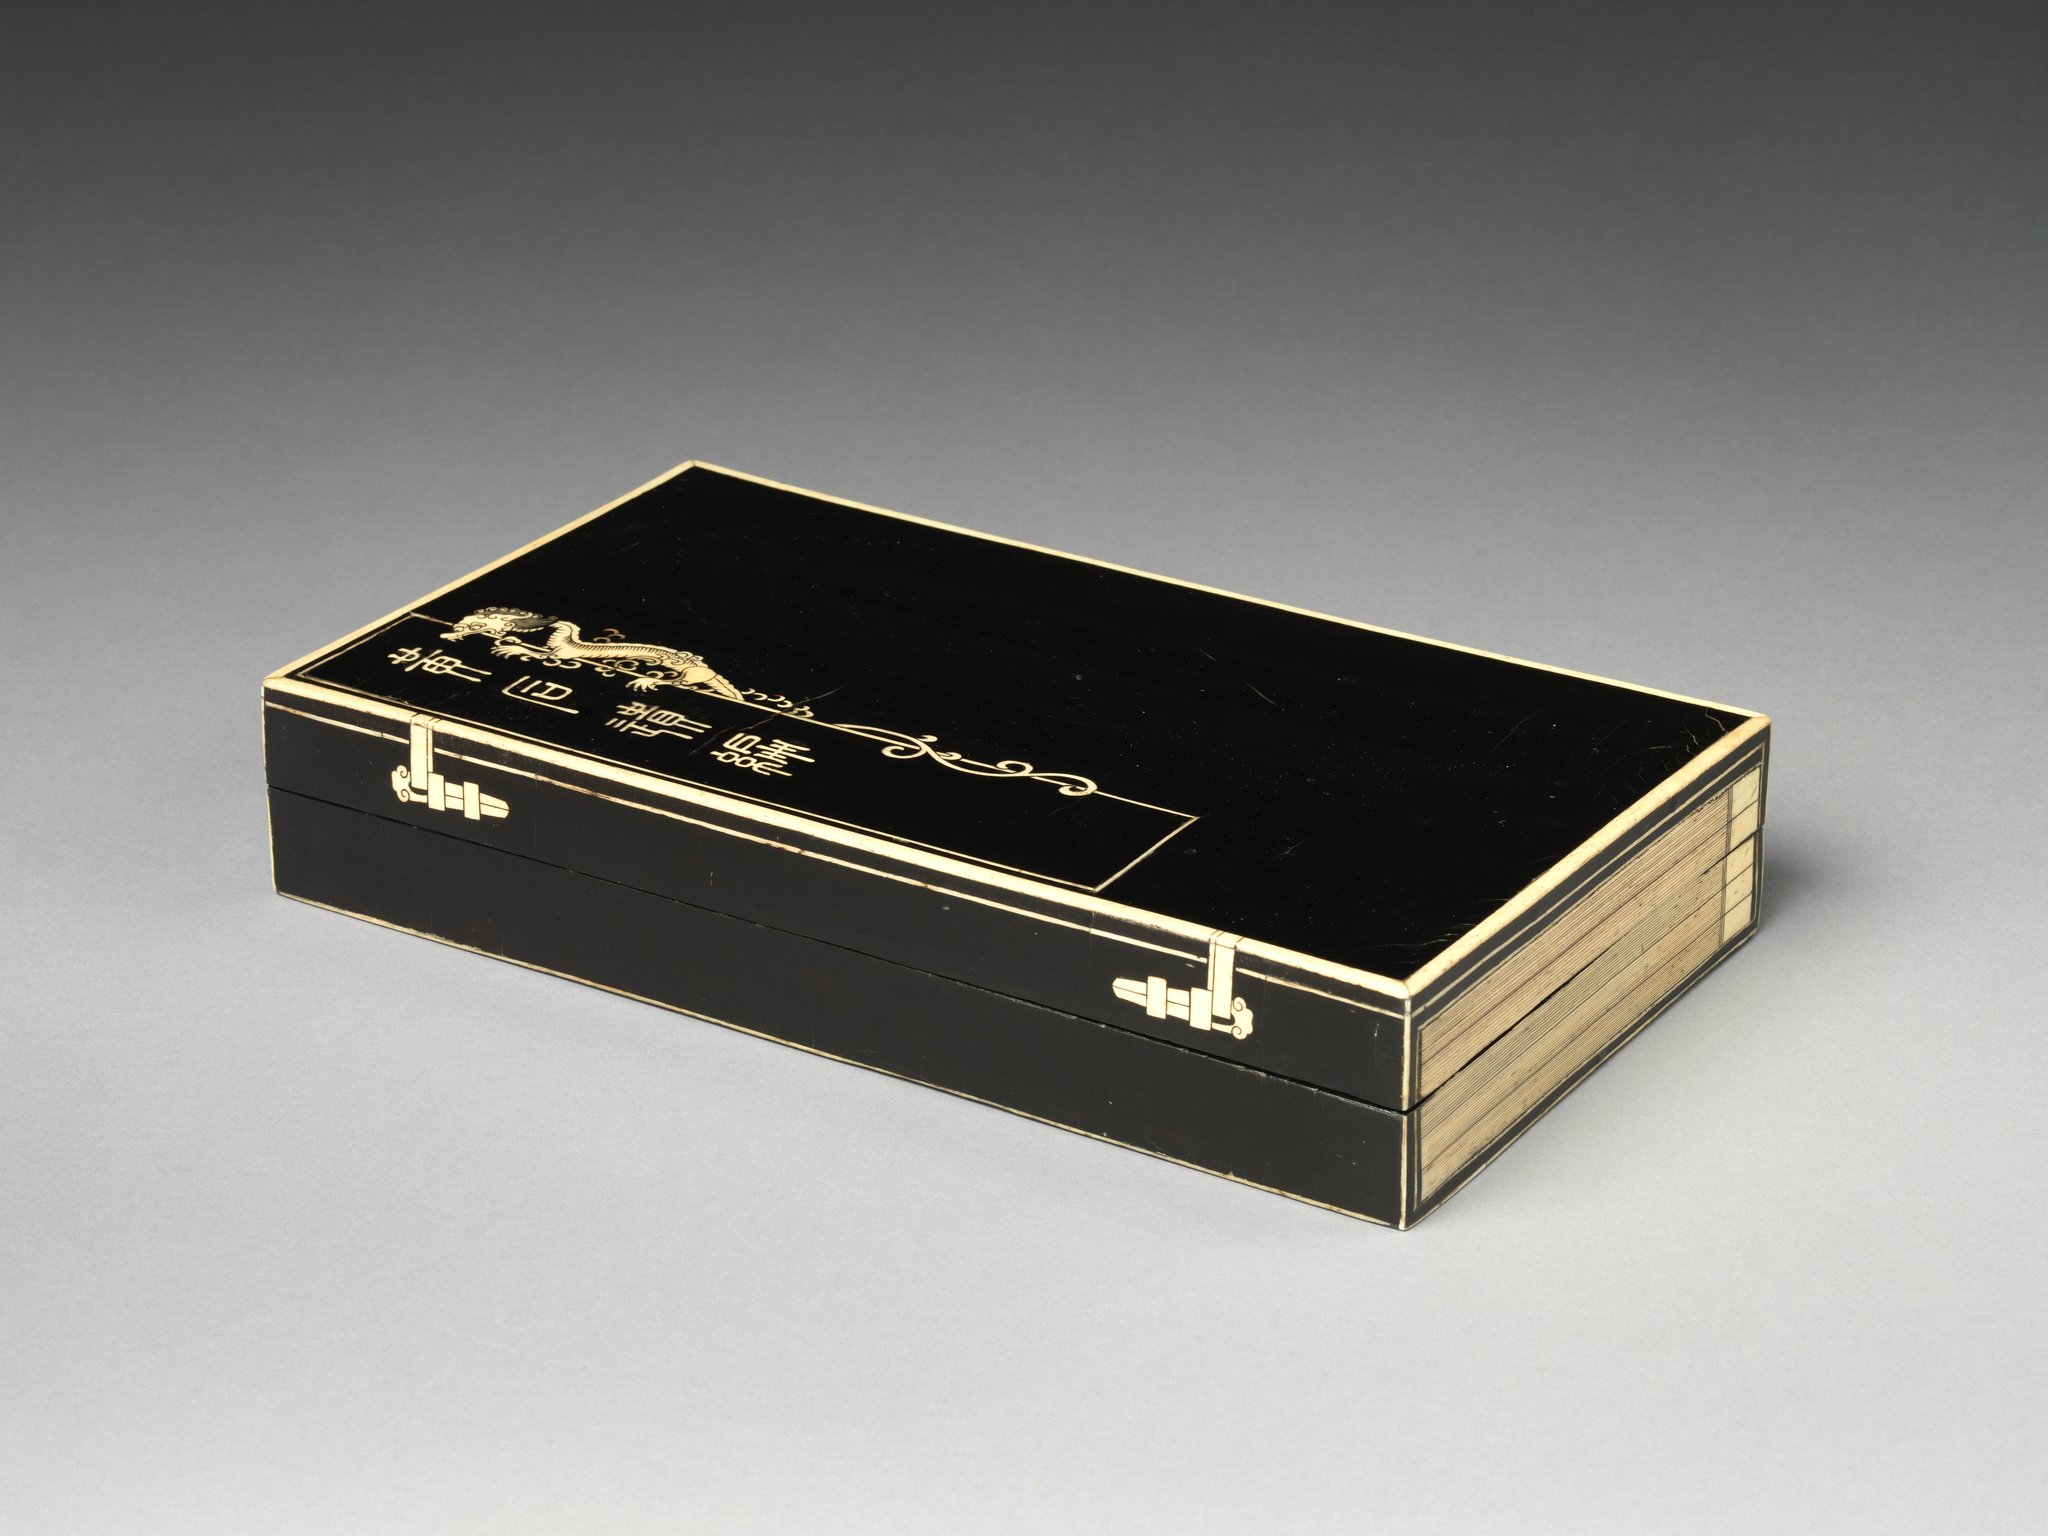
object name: box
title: Rectangular box in imitation of a pack of books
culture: chinese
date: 1701-1800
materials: bone, lacquer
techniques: inlay